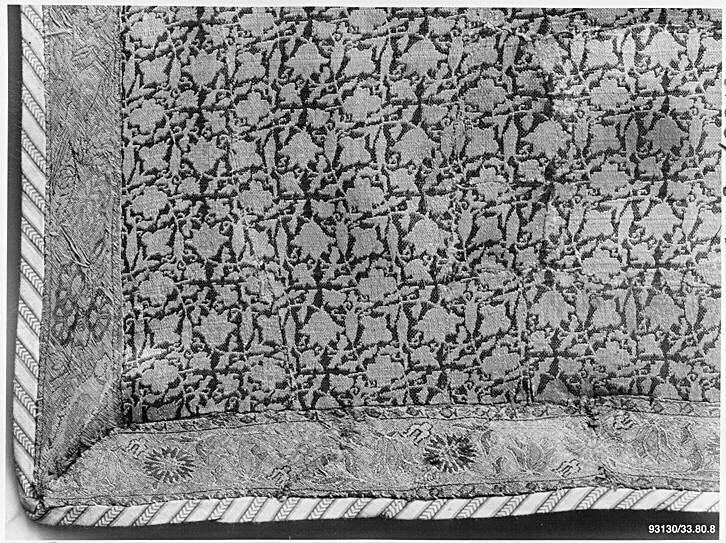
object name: cover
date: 1701-1800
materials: metal thread, silk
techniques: brocade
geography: iran